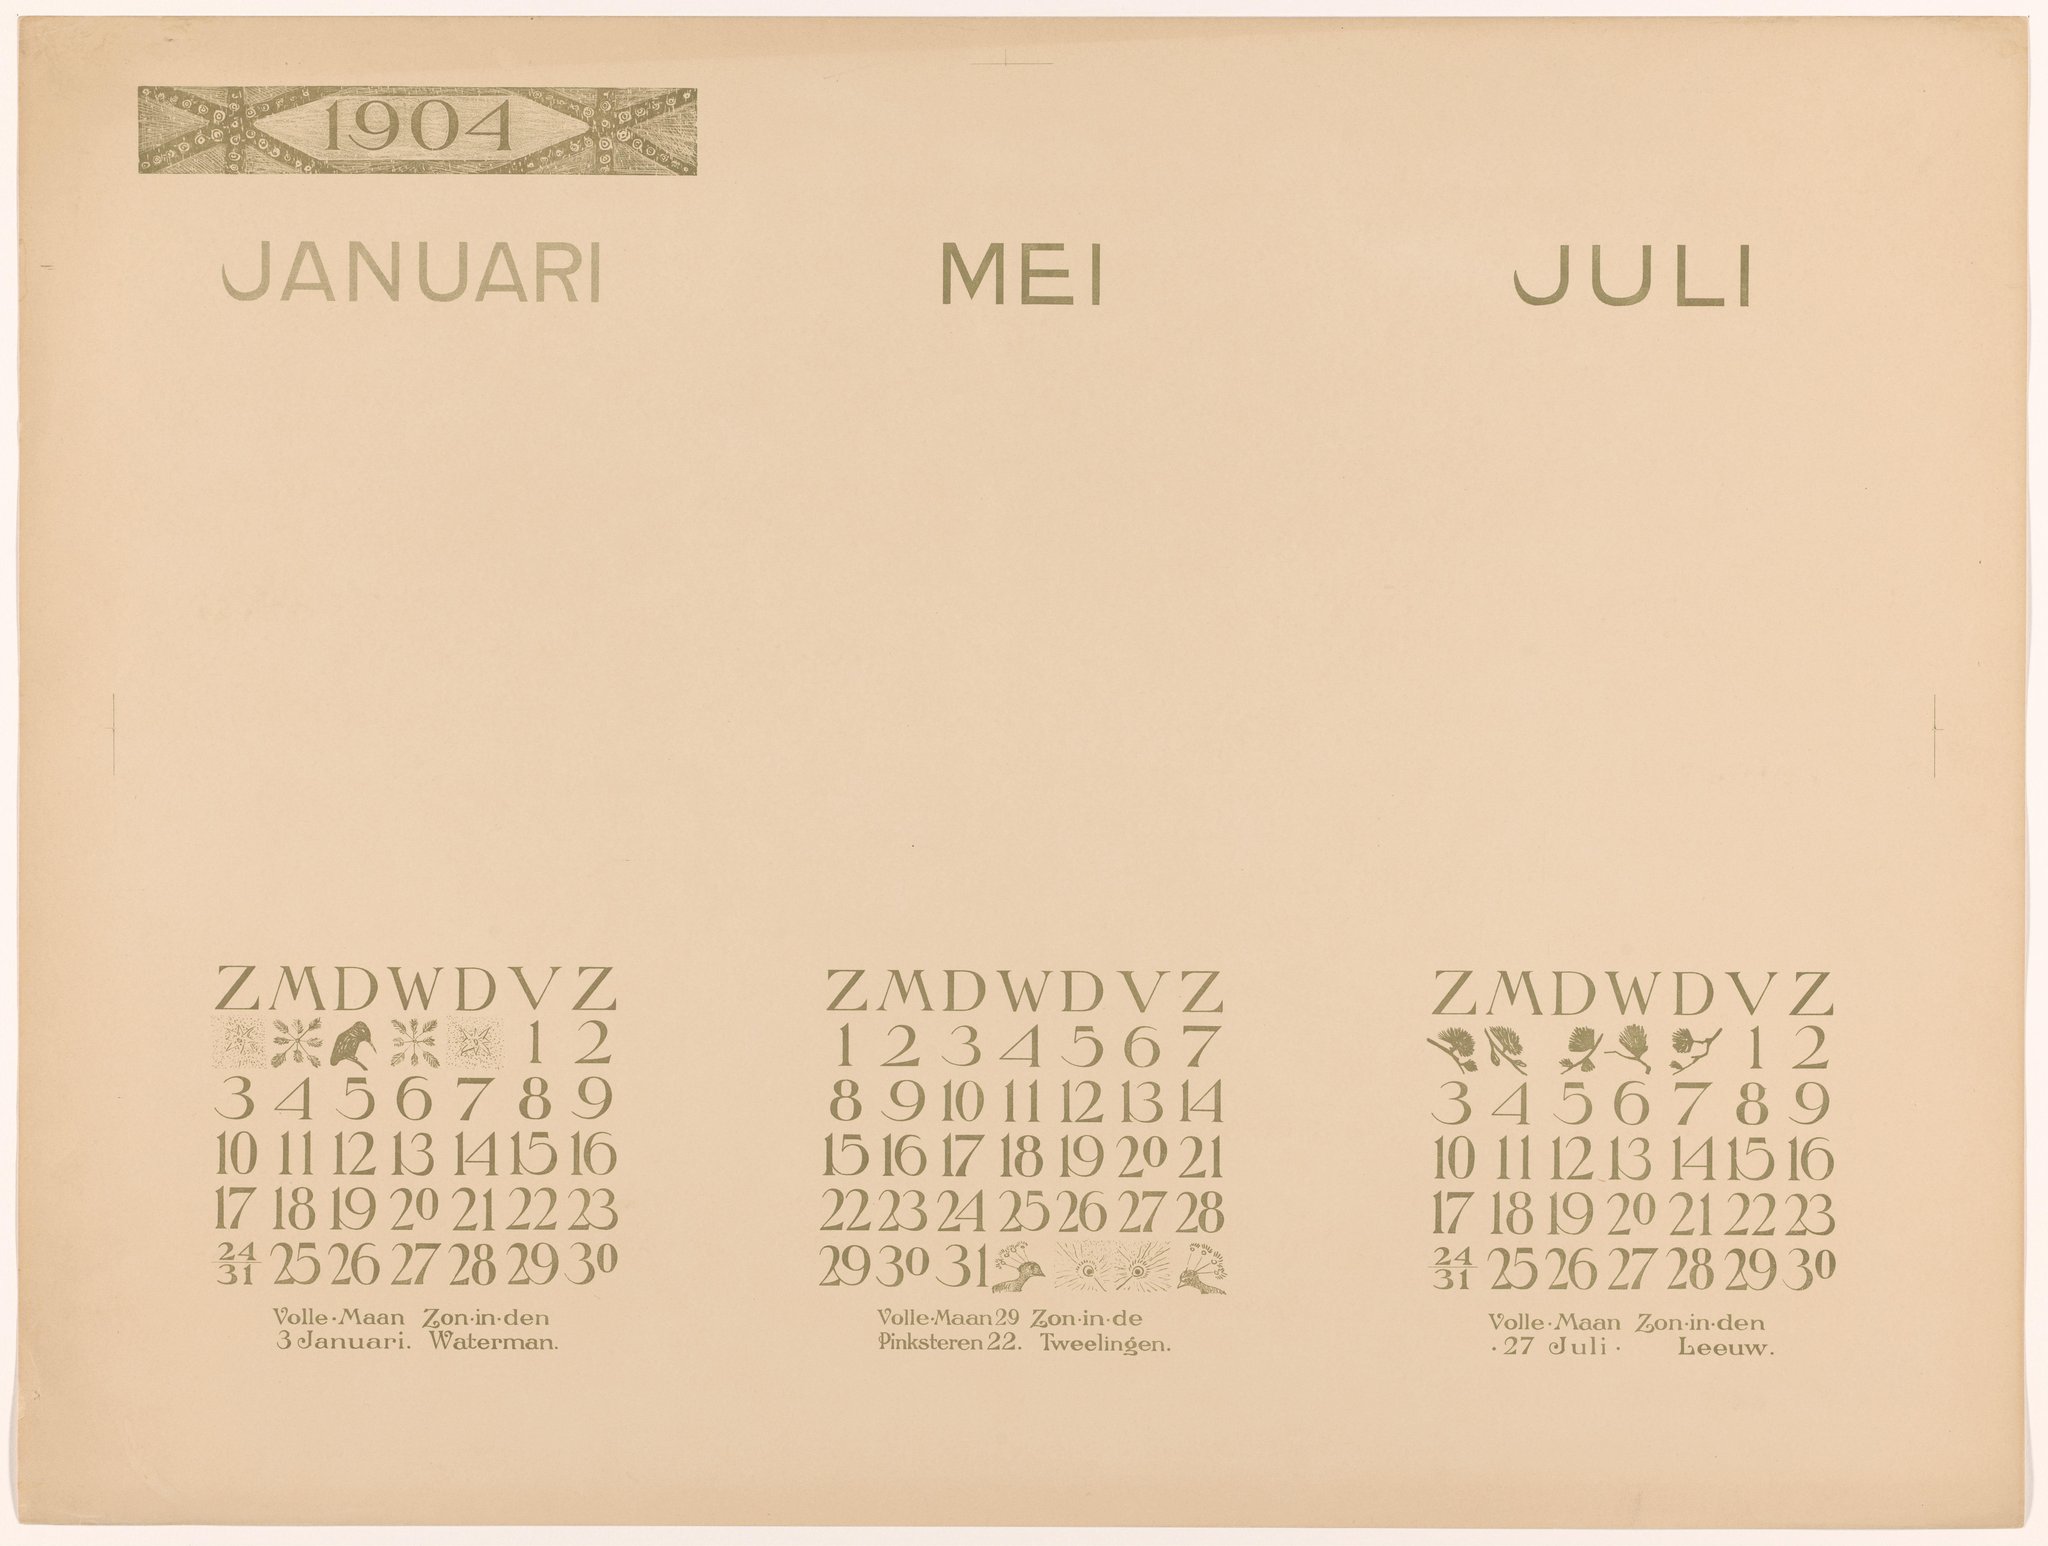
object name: print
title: Kalenders voor januari, mei en juli 1904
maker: theo van hoytema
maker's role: draughtsman, painter, print maker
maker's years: 1863-1917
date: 1904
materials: paper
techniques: lithograph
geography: amsterdam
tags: calendar, almanac, song-birds: swallow, ornamental birds: peacock, other birds: kingfisher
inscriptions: collector's mark: Lugt 2233